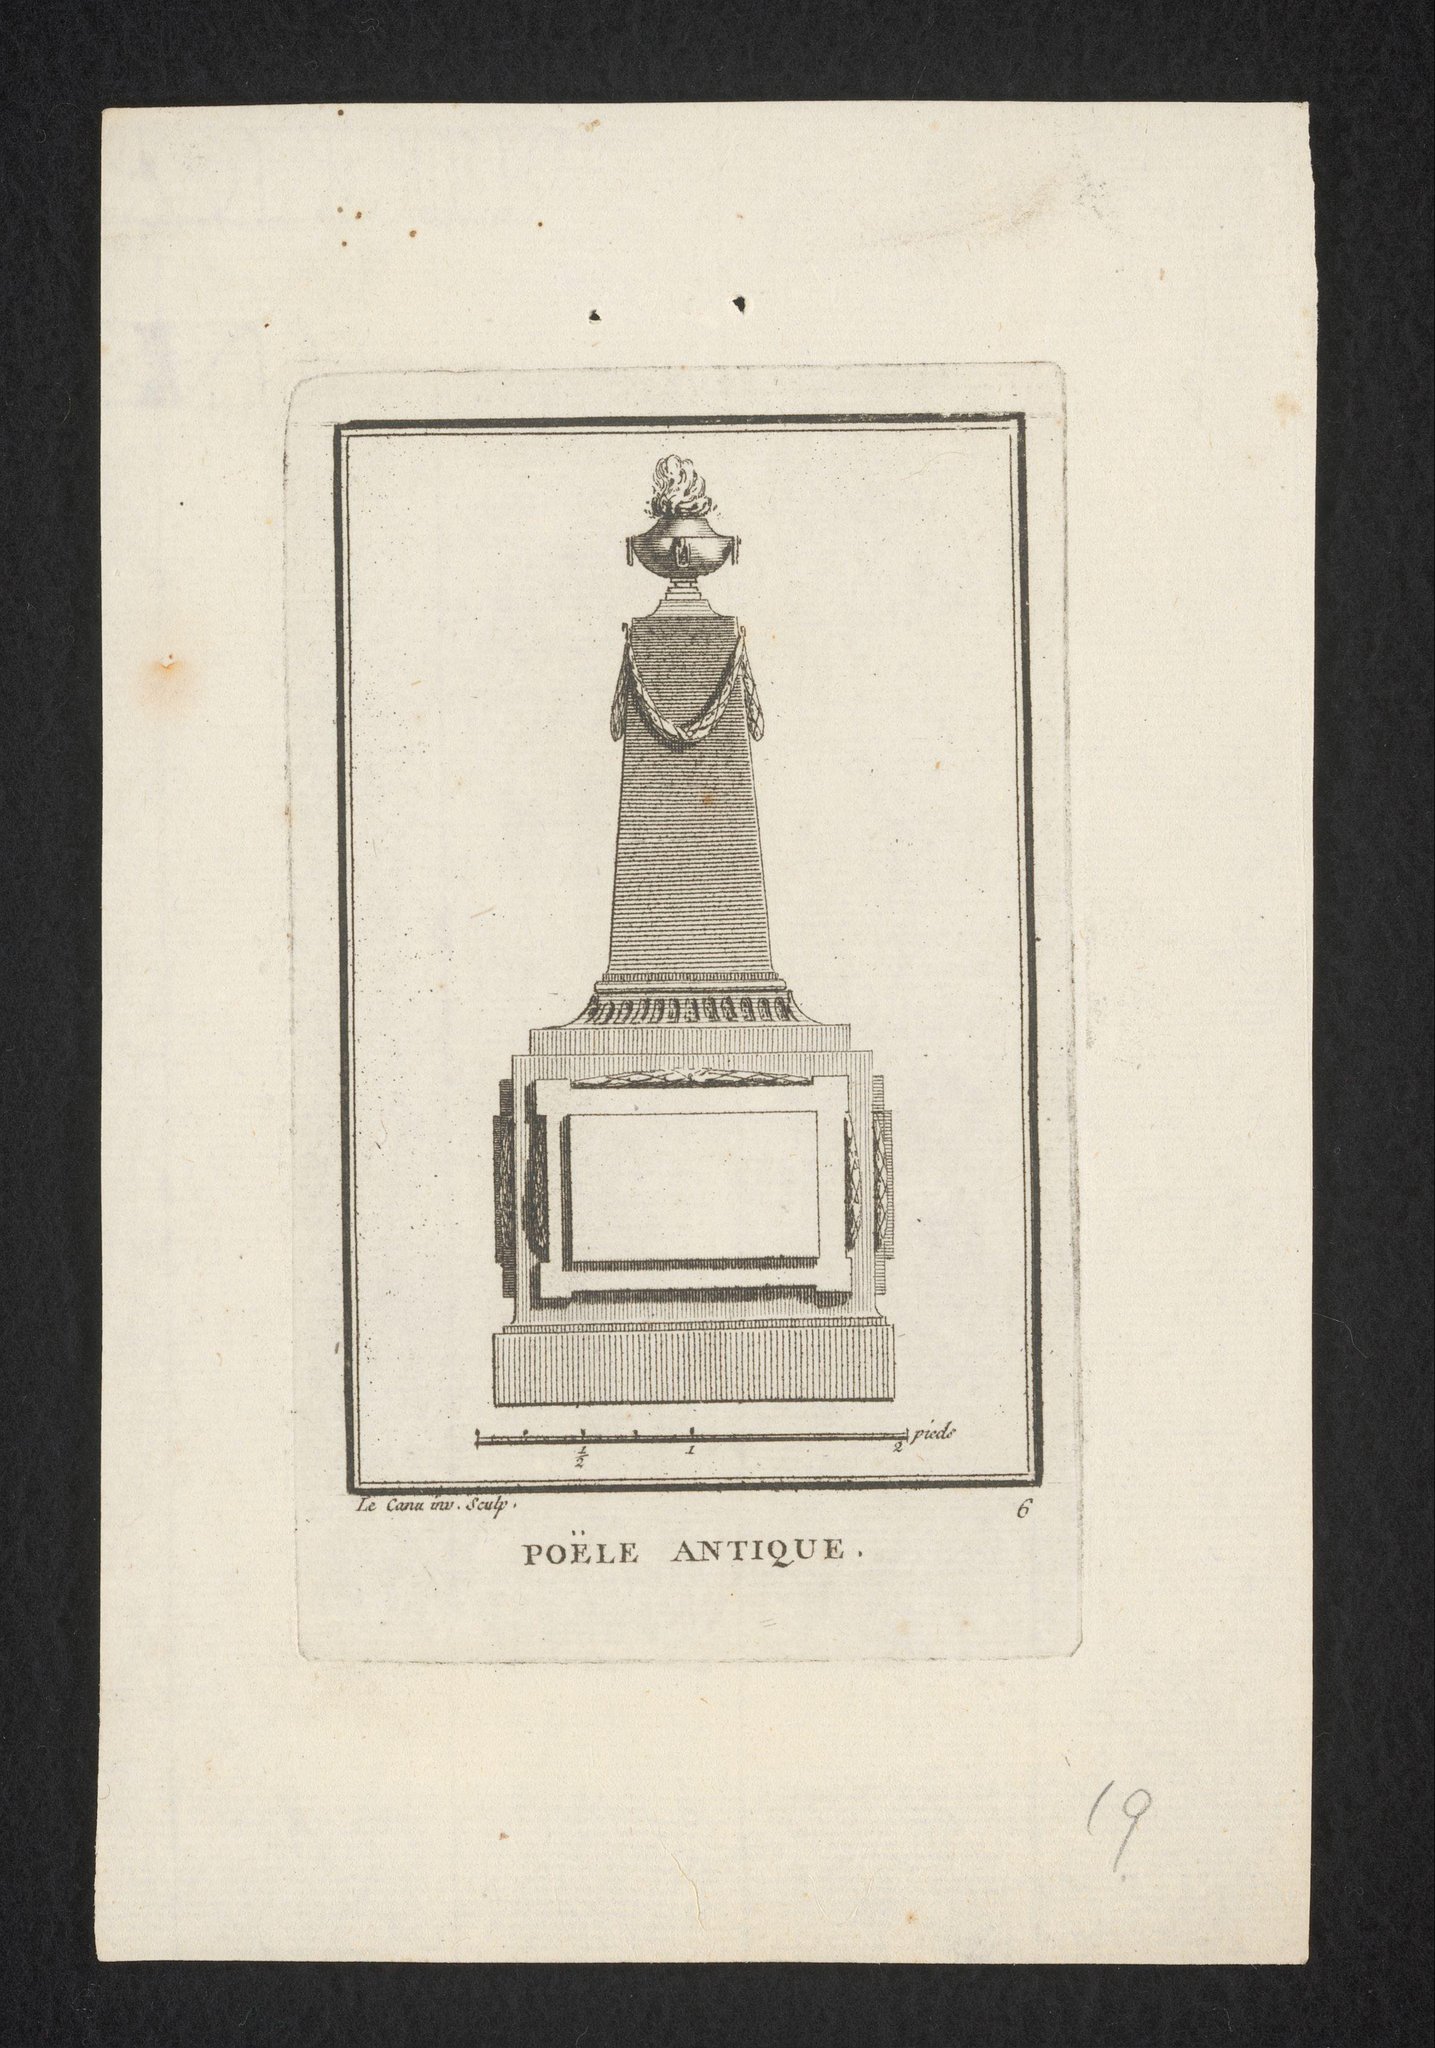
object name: print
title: Poële Antique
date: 1778-1782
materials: paper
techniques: etching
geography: paris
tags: vase ~ ornament, hearth and stove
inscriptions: collector's mark: Lugt 2760, collector's mark: Lugt 2228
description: Ontwerp voor een haard of kachel met een rechthoekig tablet en een vaas op een rechthoekige zuil met guirlandes.